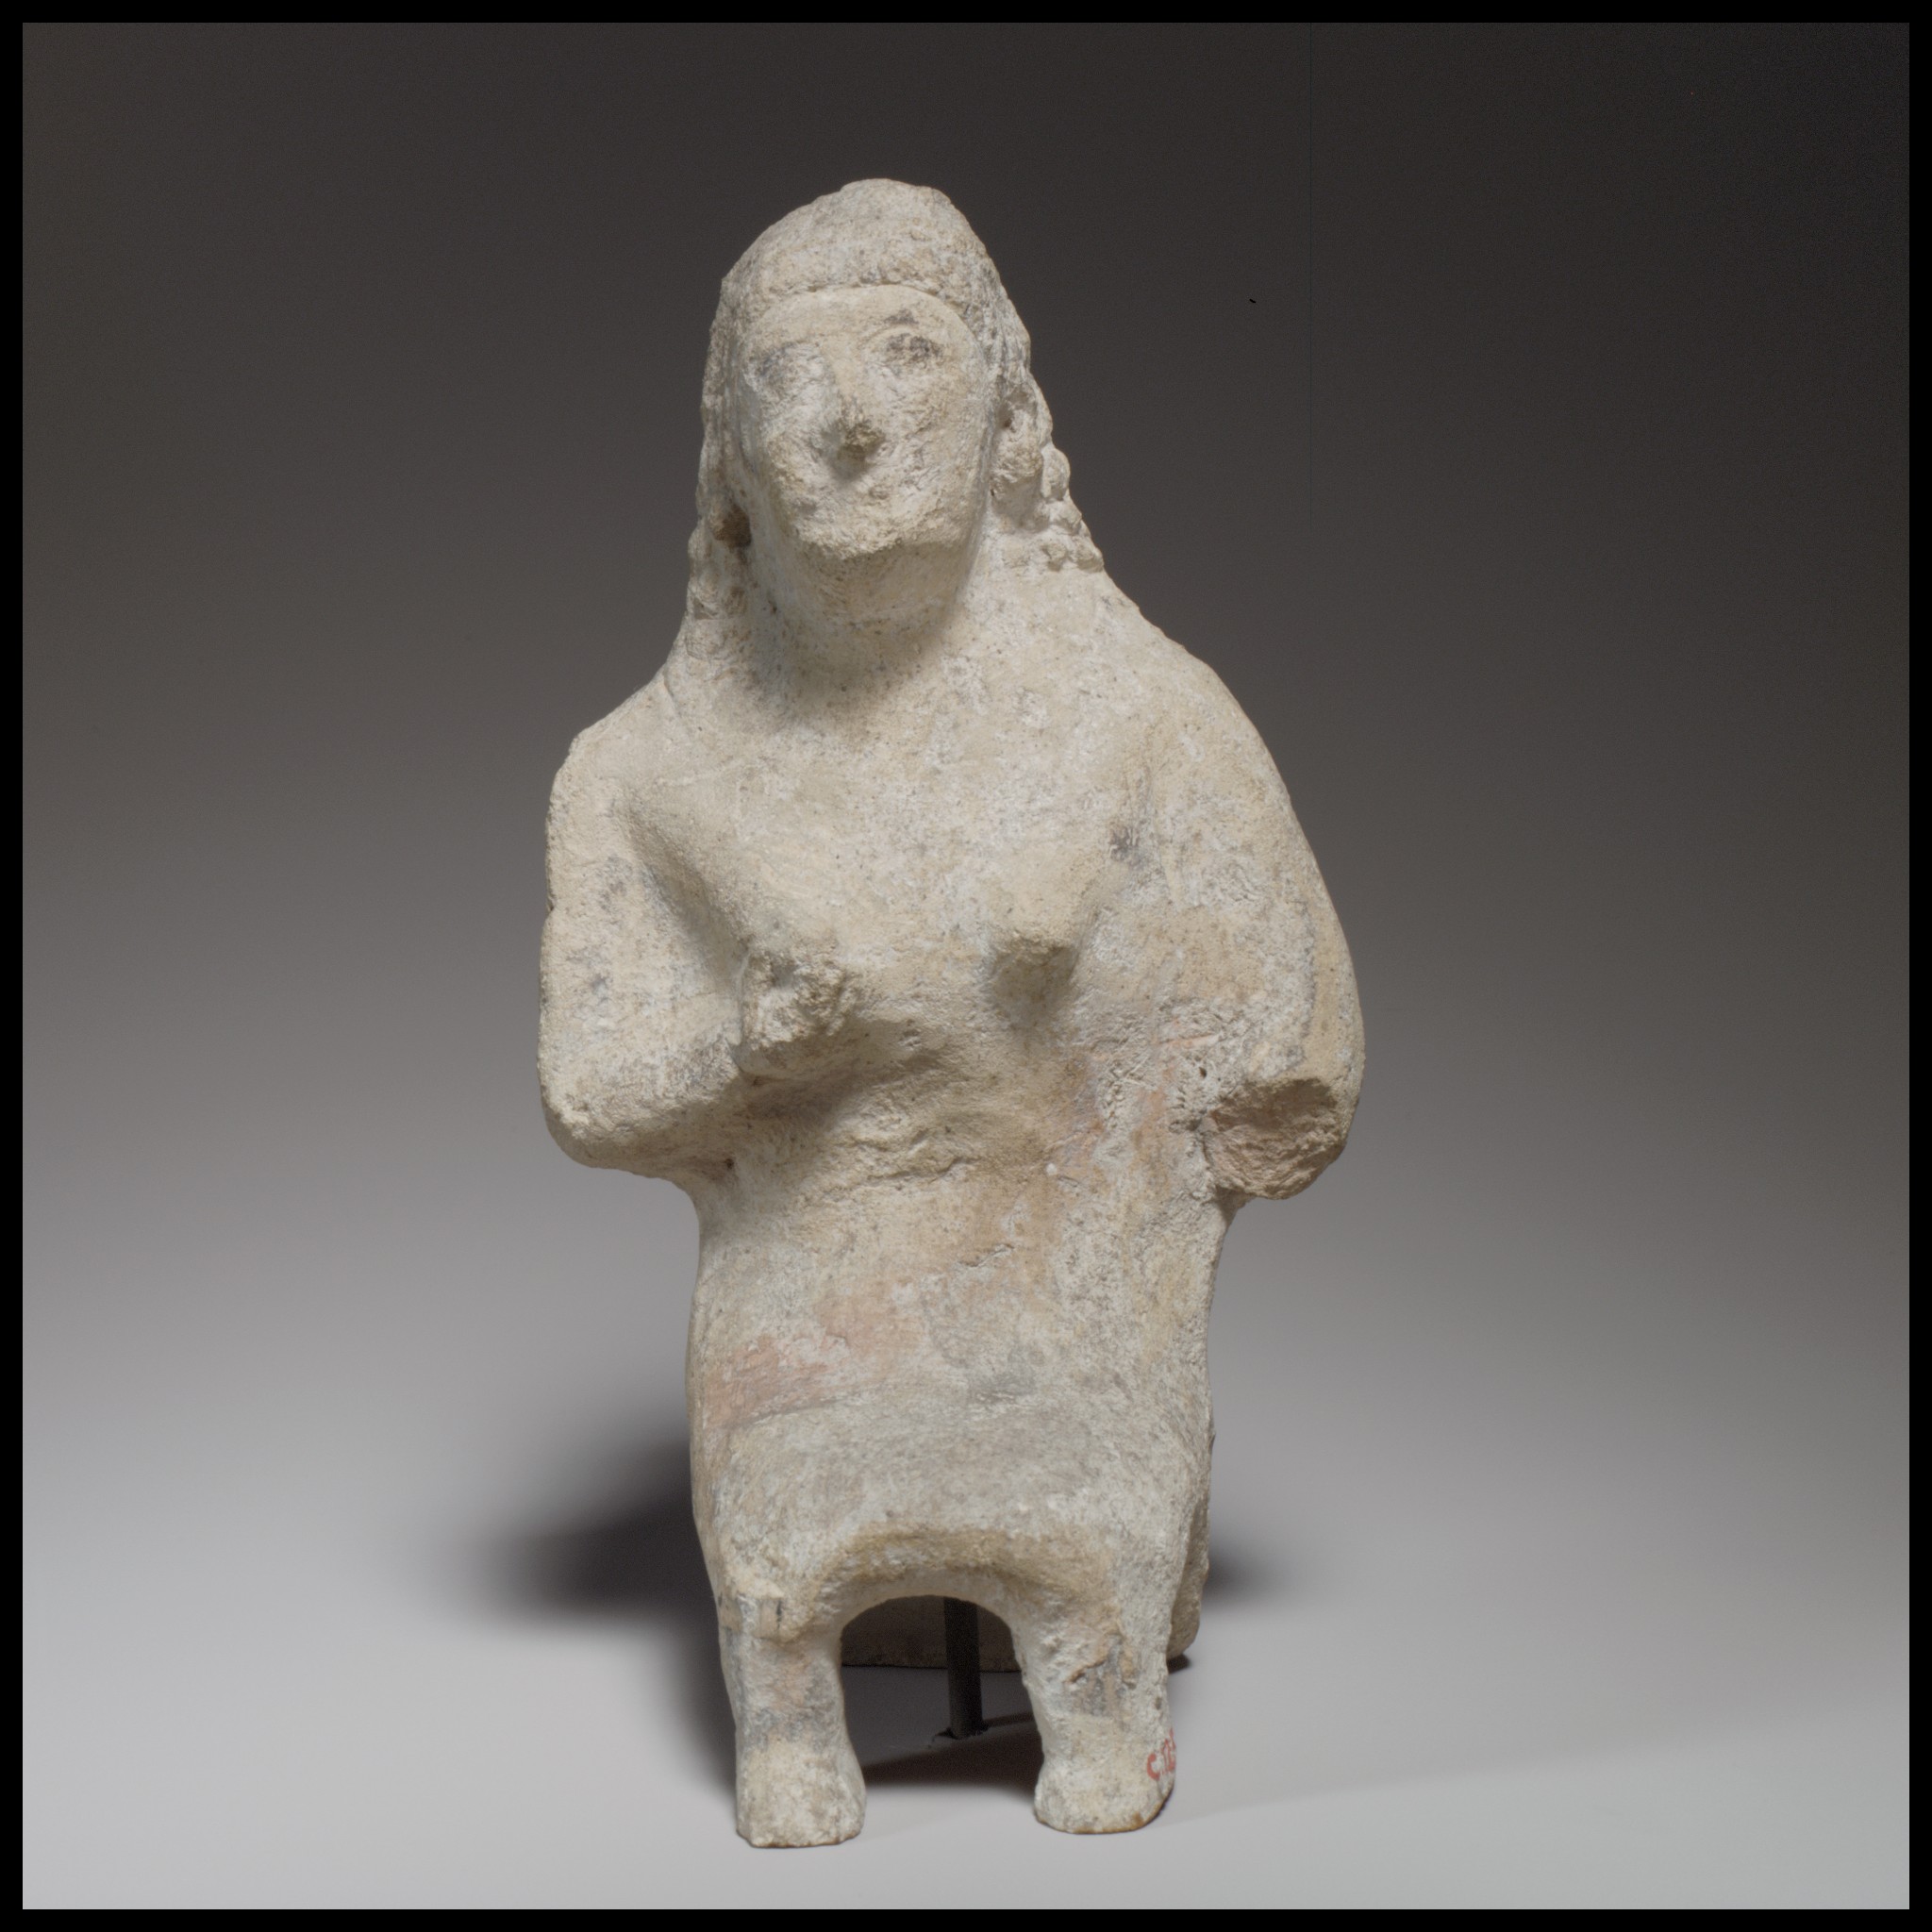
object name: statuette of a woman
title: Seated female figurine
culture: cypriot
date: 600-480 BCE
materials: terracotta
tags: women